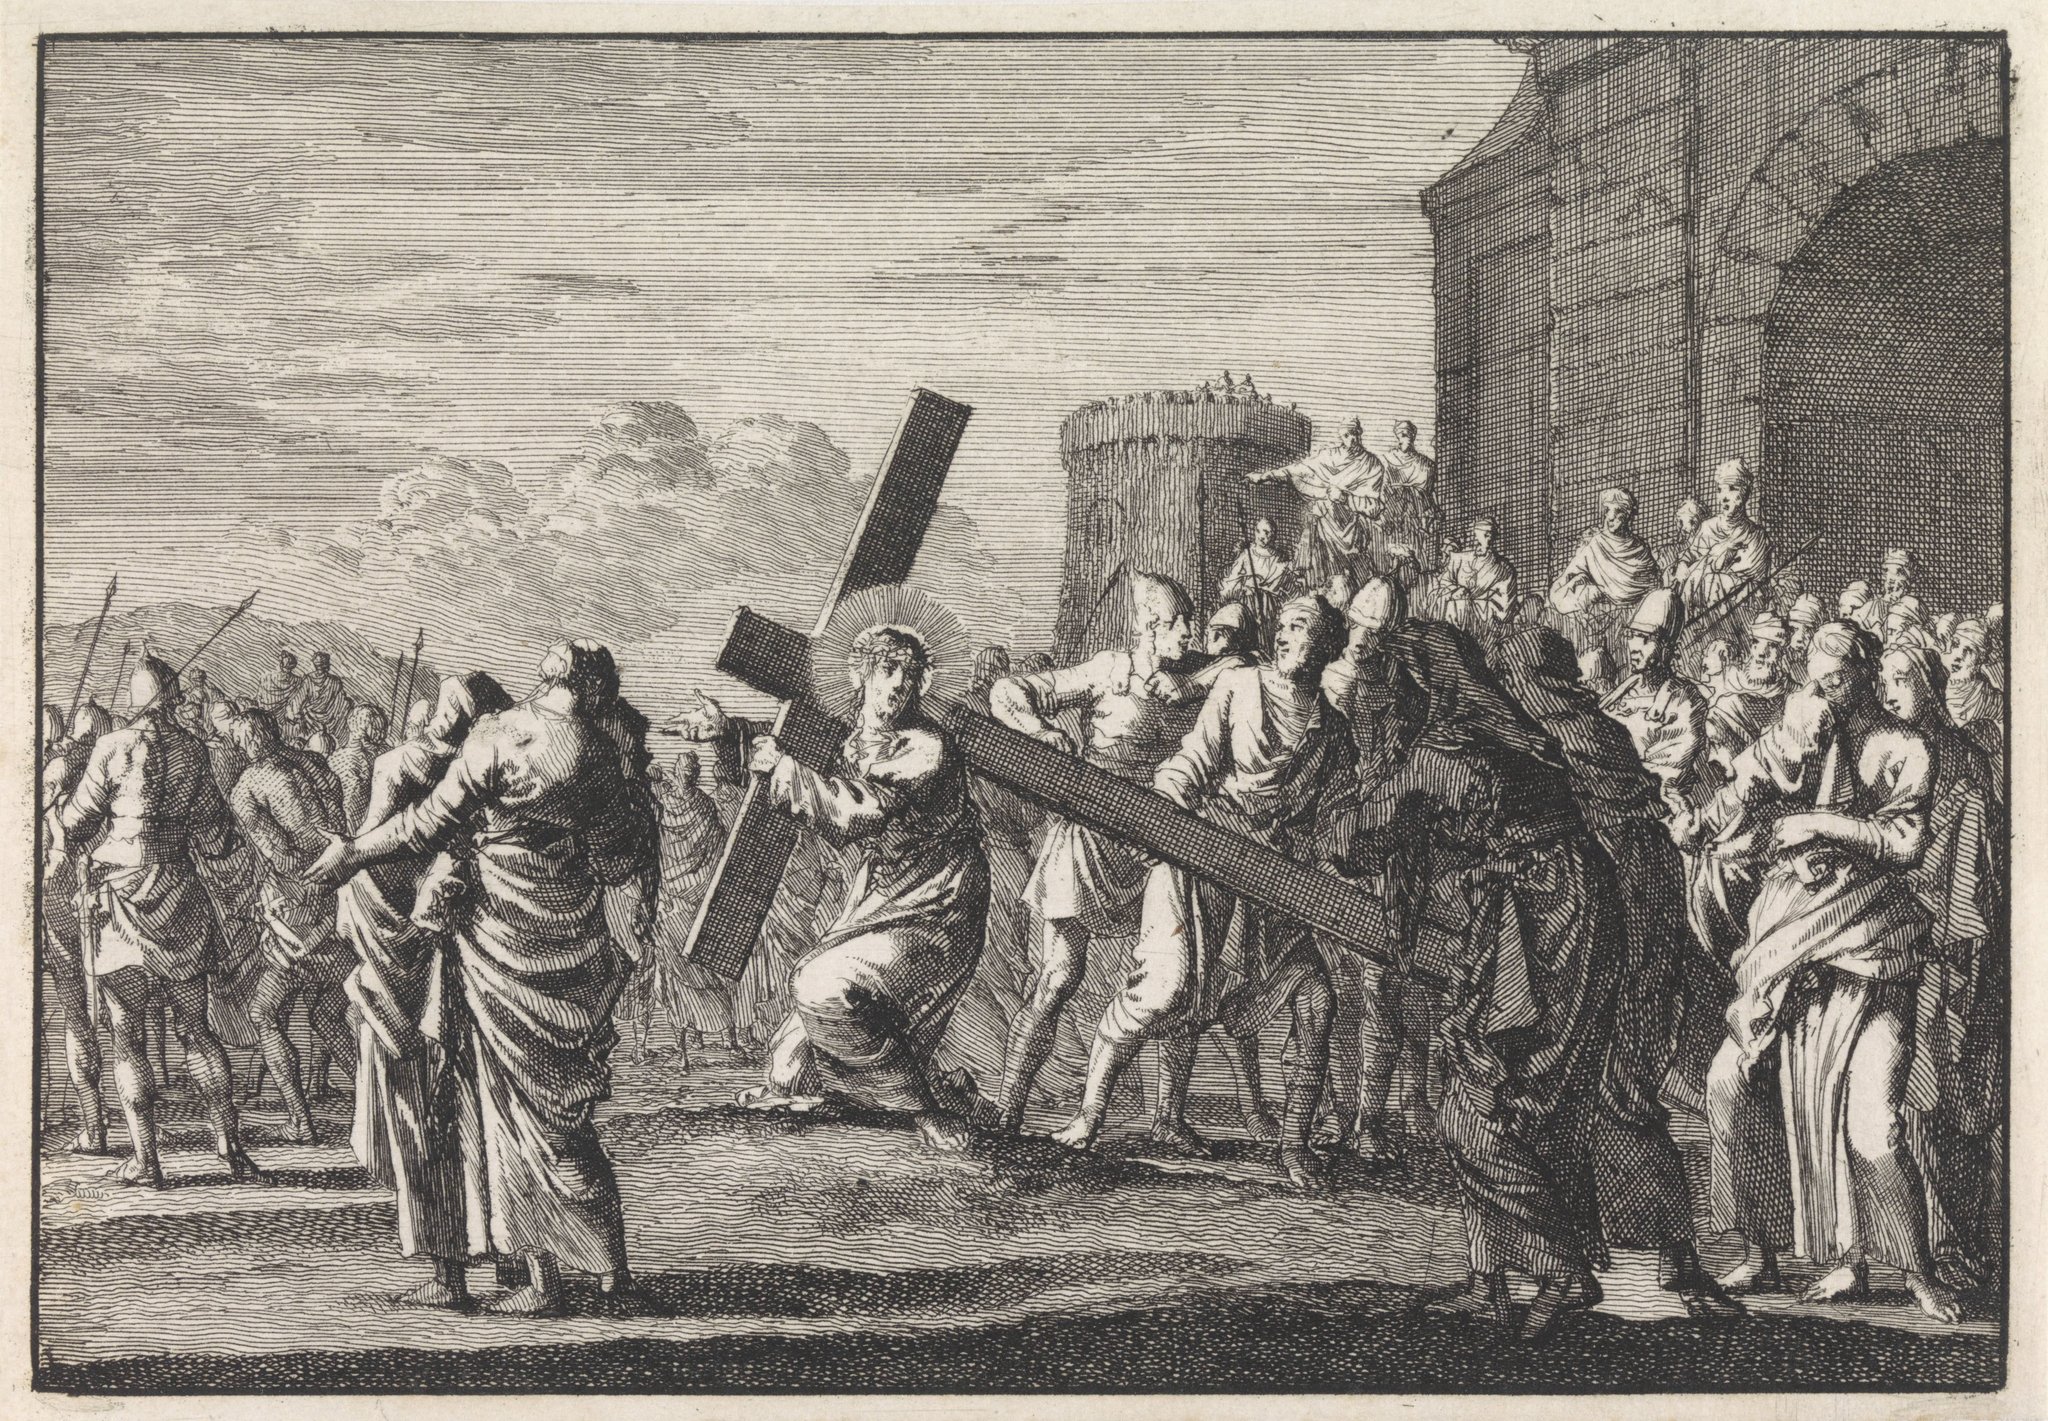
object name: print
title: Kruisdraging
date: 1703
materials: paper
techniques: etching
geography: amsterdam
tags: carrying of the cross: christ bearing the cross, alone or with the help of others (e.g. simon the cyrenian)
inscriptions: collector's mark: Lugt 2228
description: Proefdruk van een boekillustratie voor David Martin. Historie des Ouden en Nieuwen Testaments. Amsterdam, Pieter Mortier, 1703. Deel II. De boekillustraties voor de Mortierbijbel hebben verschillende staten en kopieën, waarbij de chronologische volgorde moeilijk te achterhalen valt. Als boekillustraties werden ze bovendien herhaaldelijk opnieuw gebruikt voor andere boekwerken.